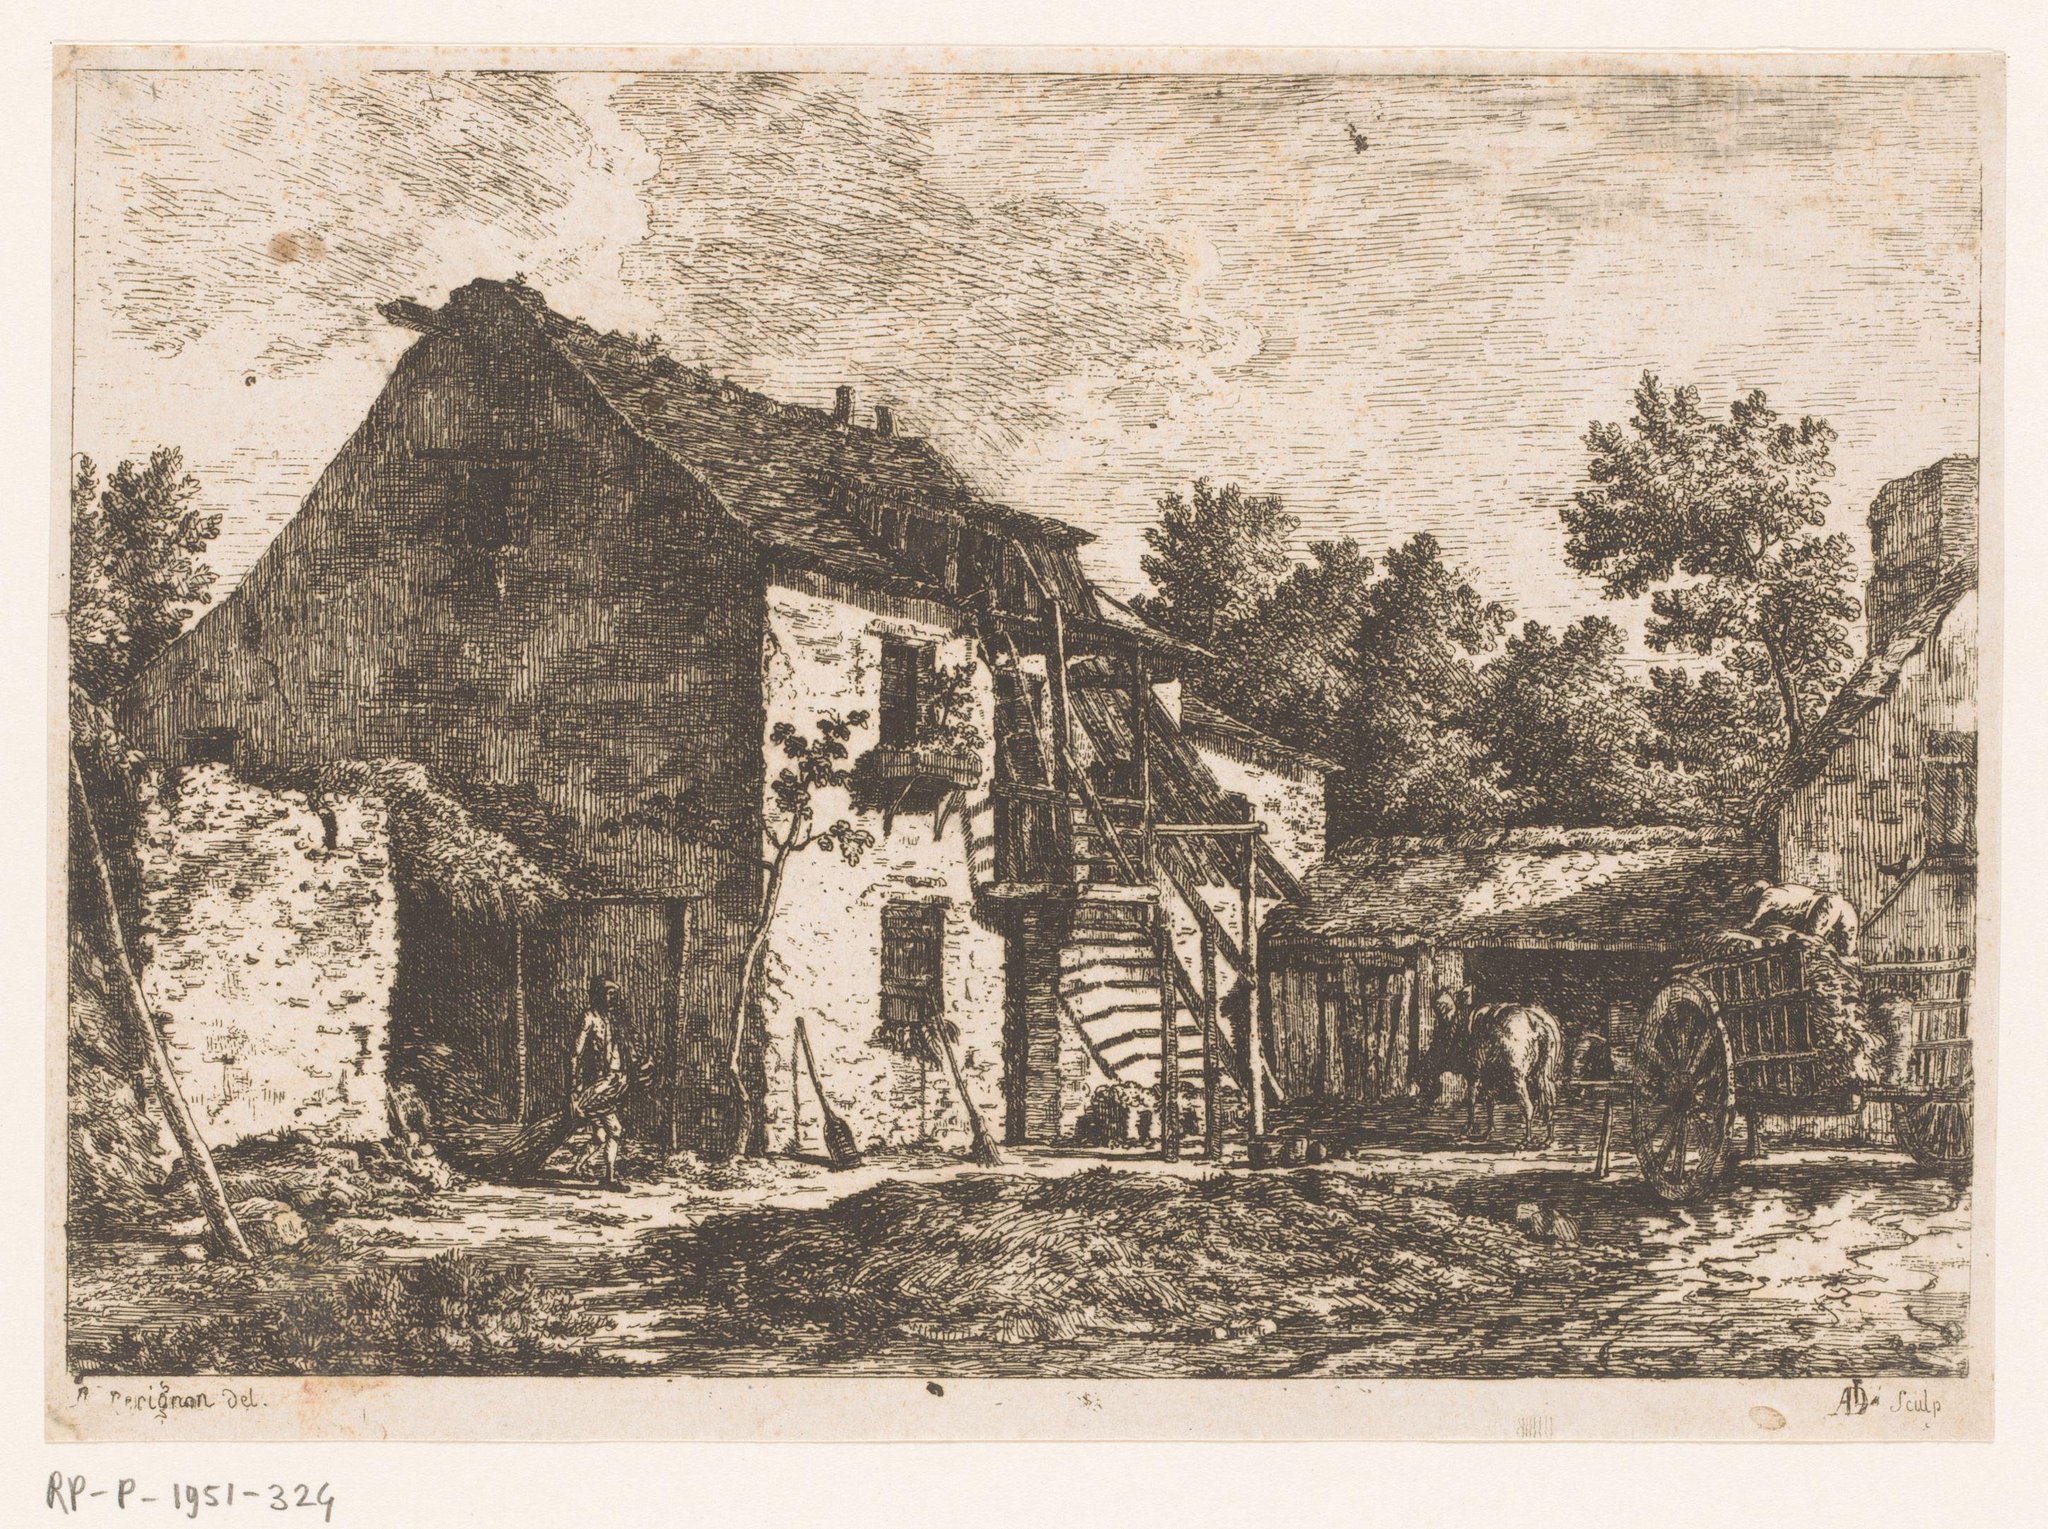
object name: print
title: Boerderij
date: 1780-1900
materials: paper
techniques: etching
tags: farm or solitary house in landscape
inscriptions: collector's mark: Lugt 2228